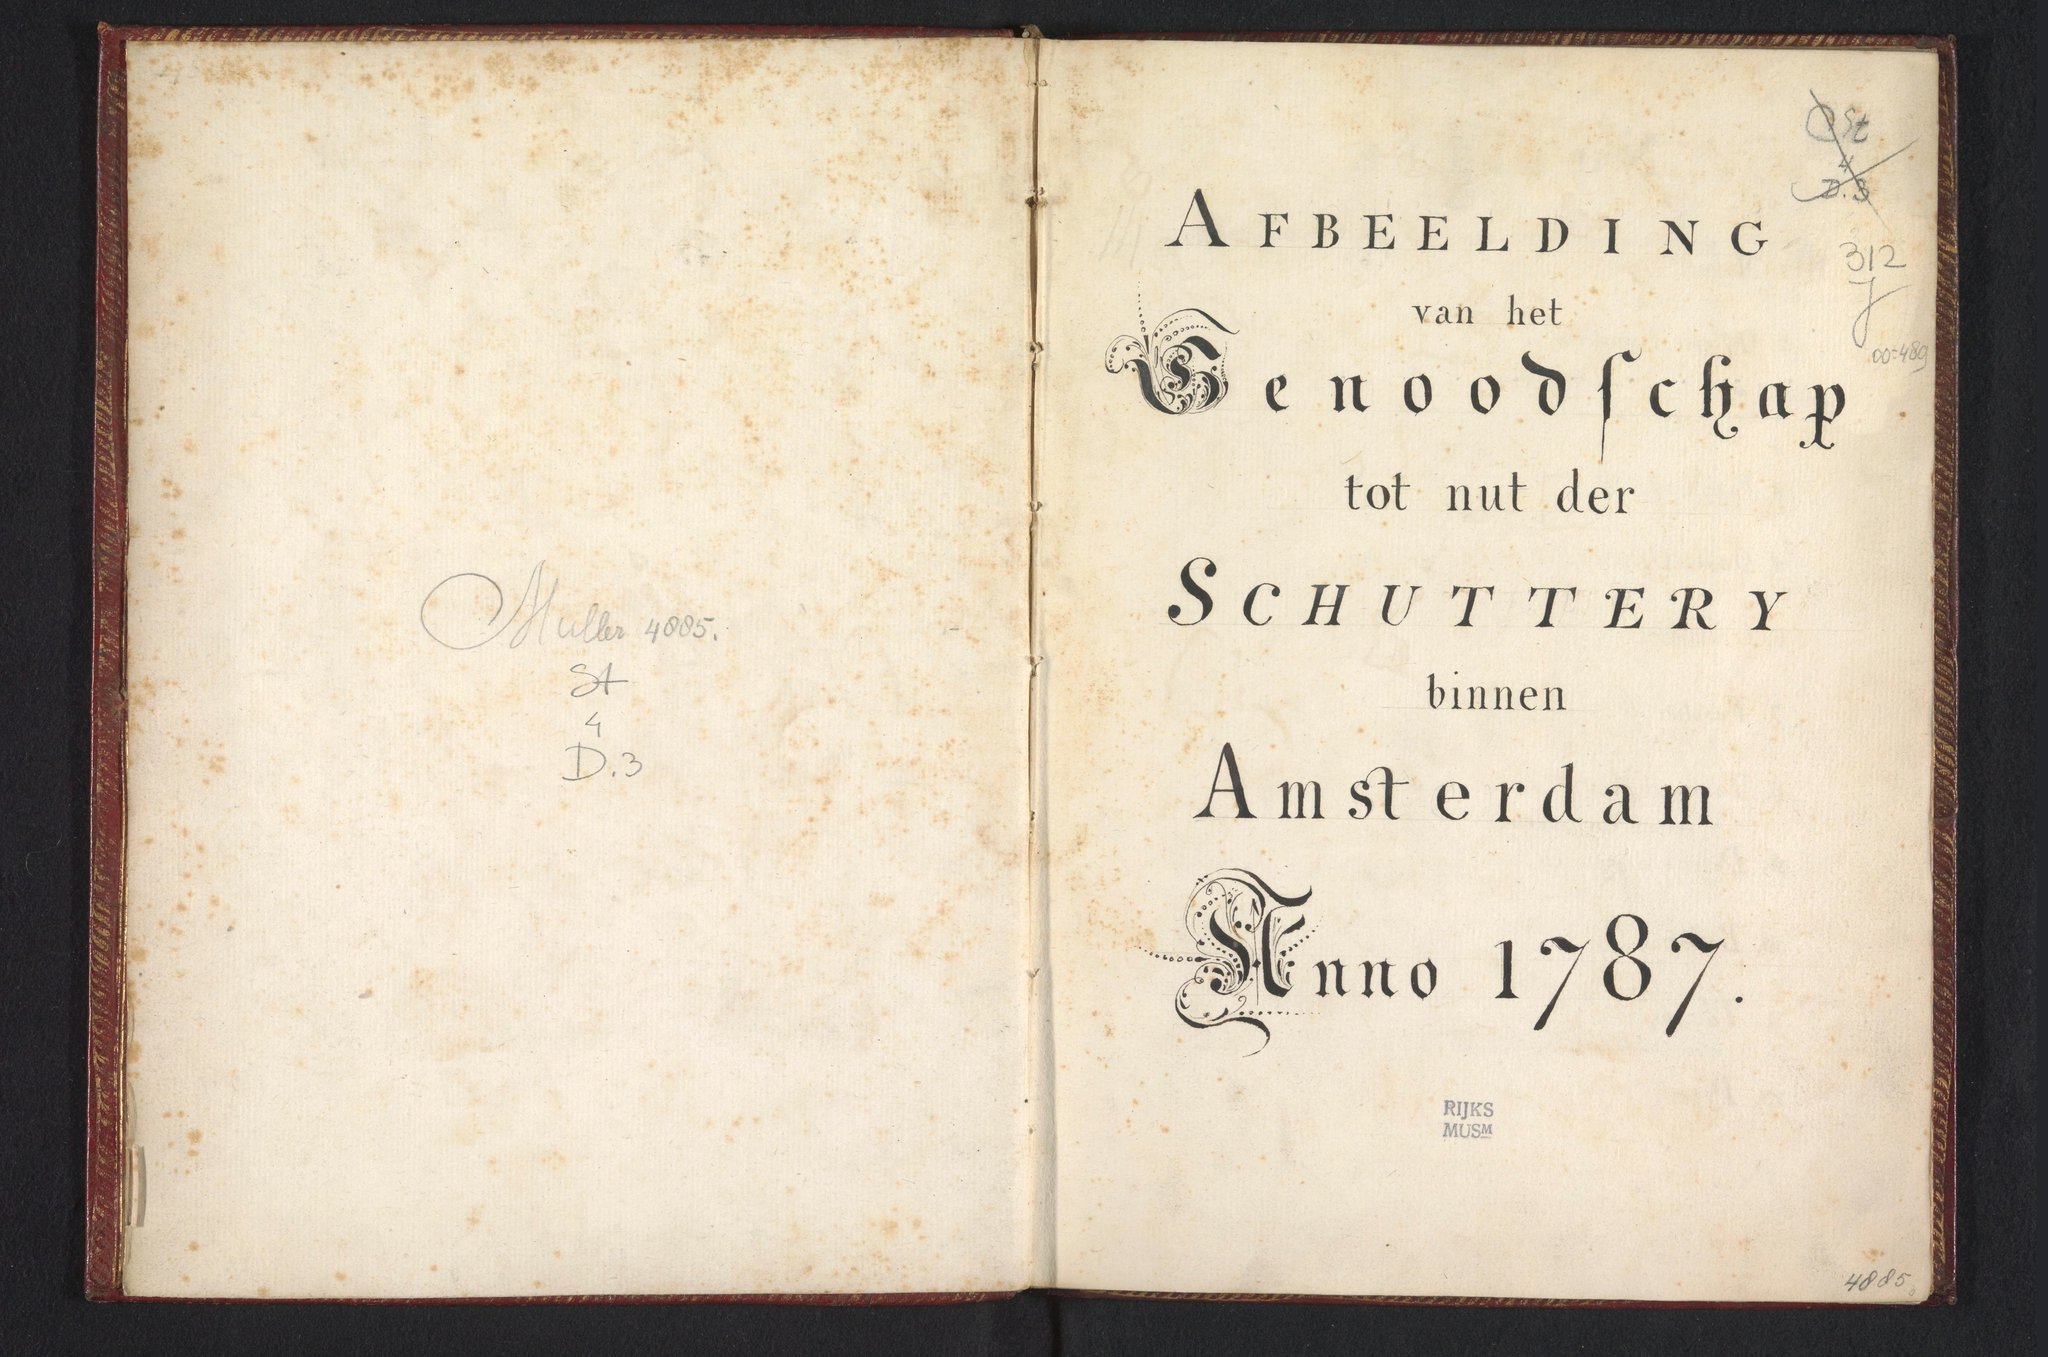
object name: manuscript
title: Titelblad van het album van de uniformen van het Genootschap tot Nut der Schutterij te Amsterdam in 1787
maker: Anonymous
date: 1787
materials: paper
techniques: writing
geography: amsterdam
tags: amsterdam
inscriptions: collector's mark: Lugt 2166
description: Handgeschreven titelblad van het album met veertien ingeplakte gekleurde tekeningen van de uniformen van schutters van het patriotse Genootschap tot Nut der Schutterij te Amsterdam in het jaar 1787.